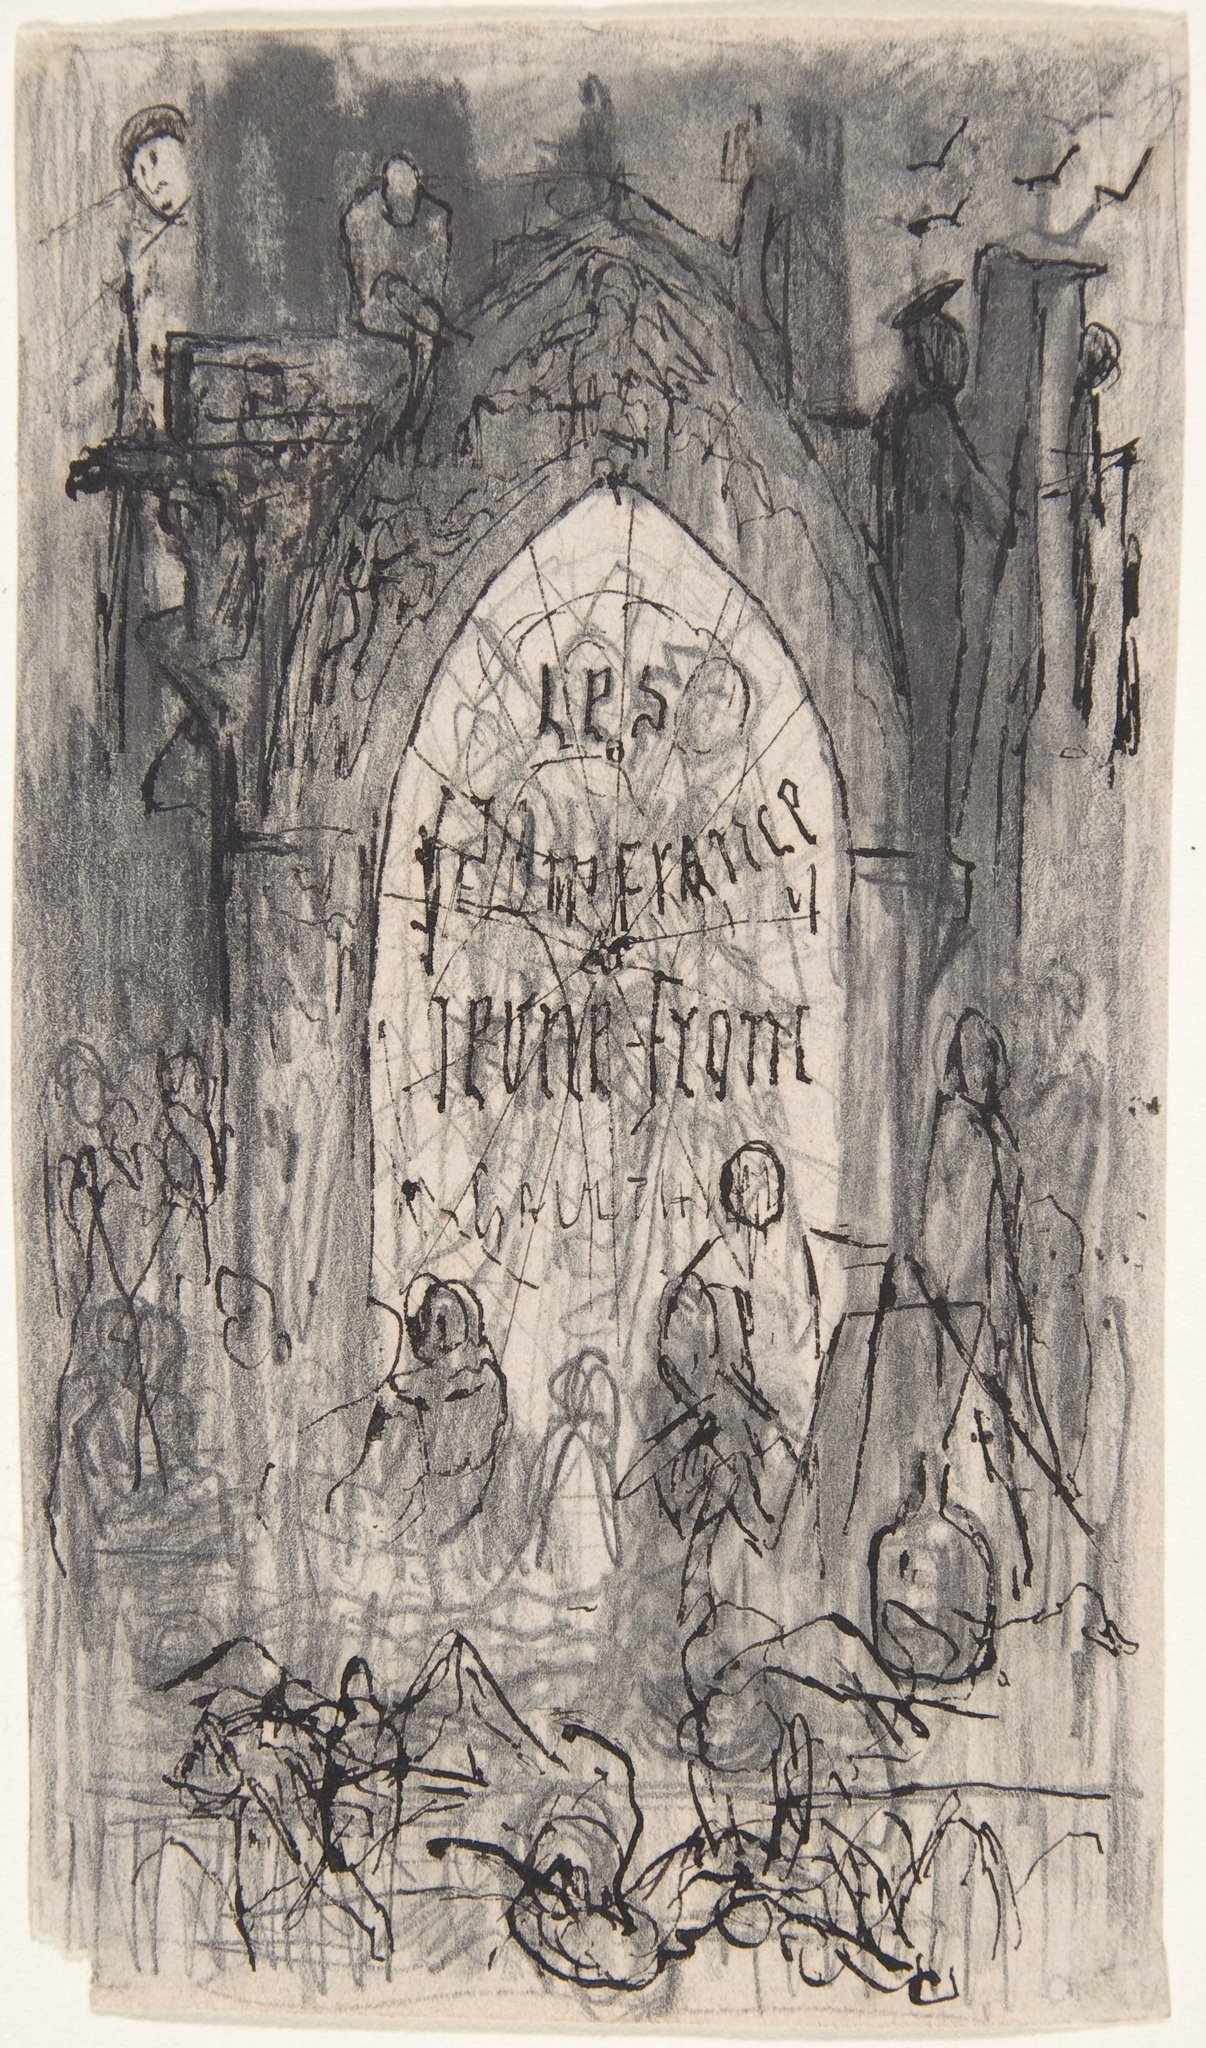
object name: drawing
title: Study for frontispiece for "Les Jeunes France" by Theophile Gautier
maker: félicien rops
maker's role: artist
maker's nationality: belgian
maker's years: 1833-1898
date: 1833-1898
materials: graphite, ink